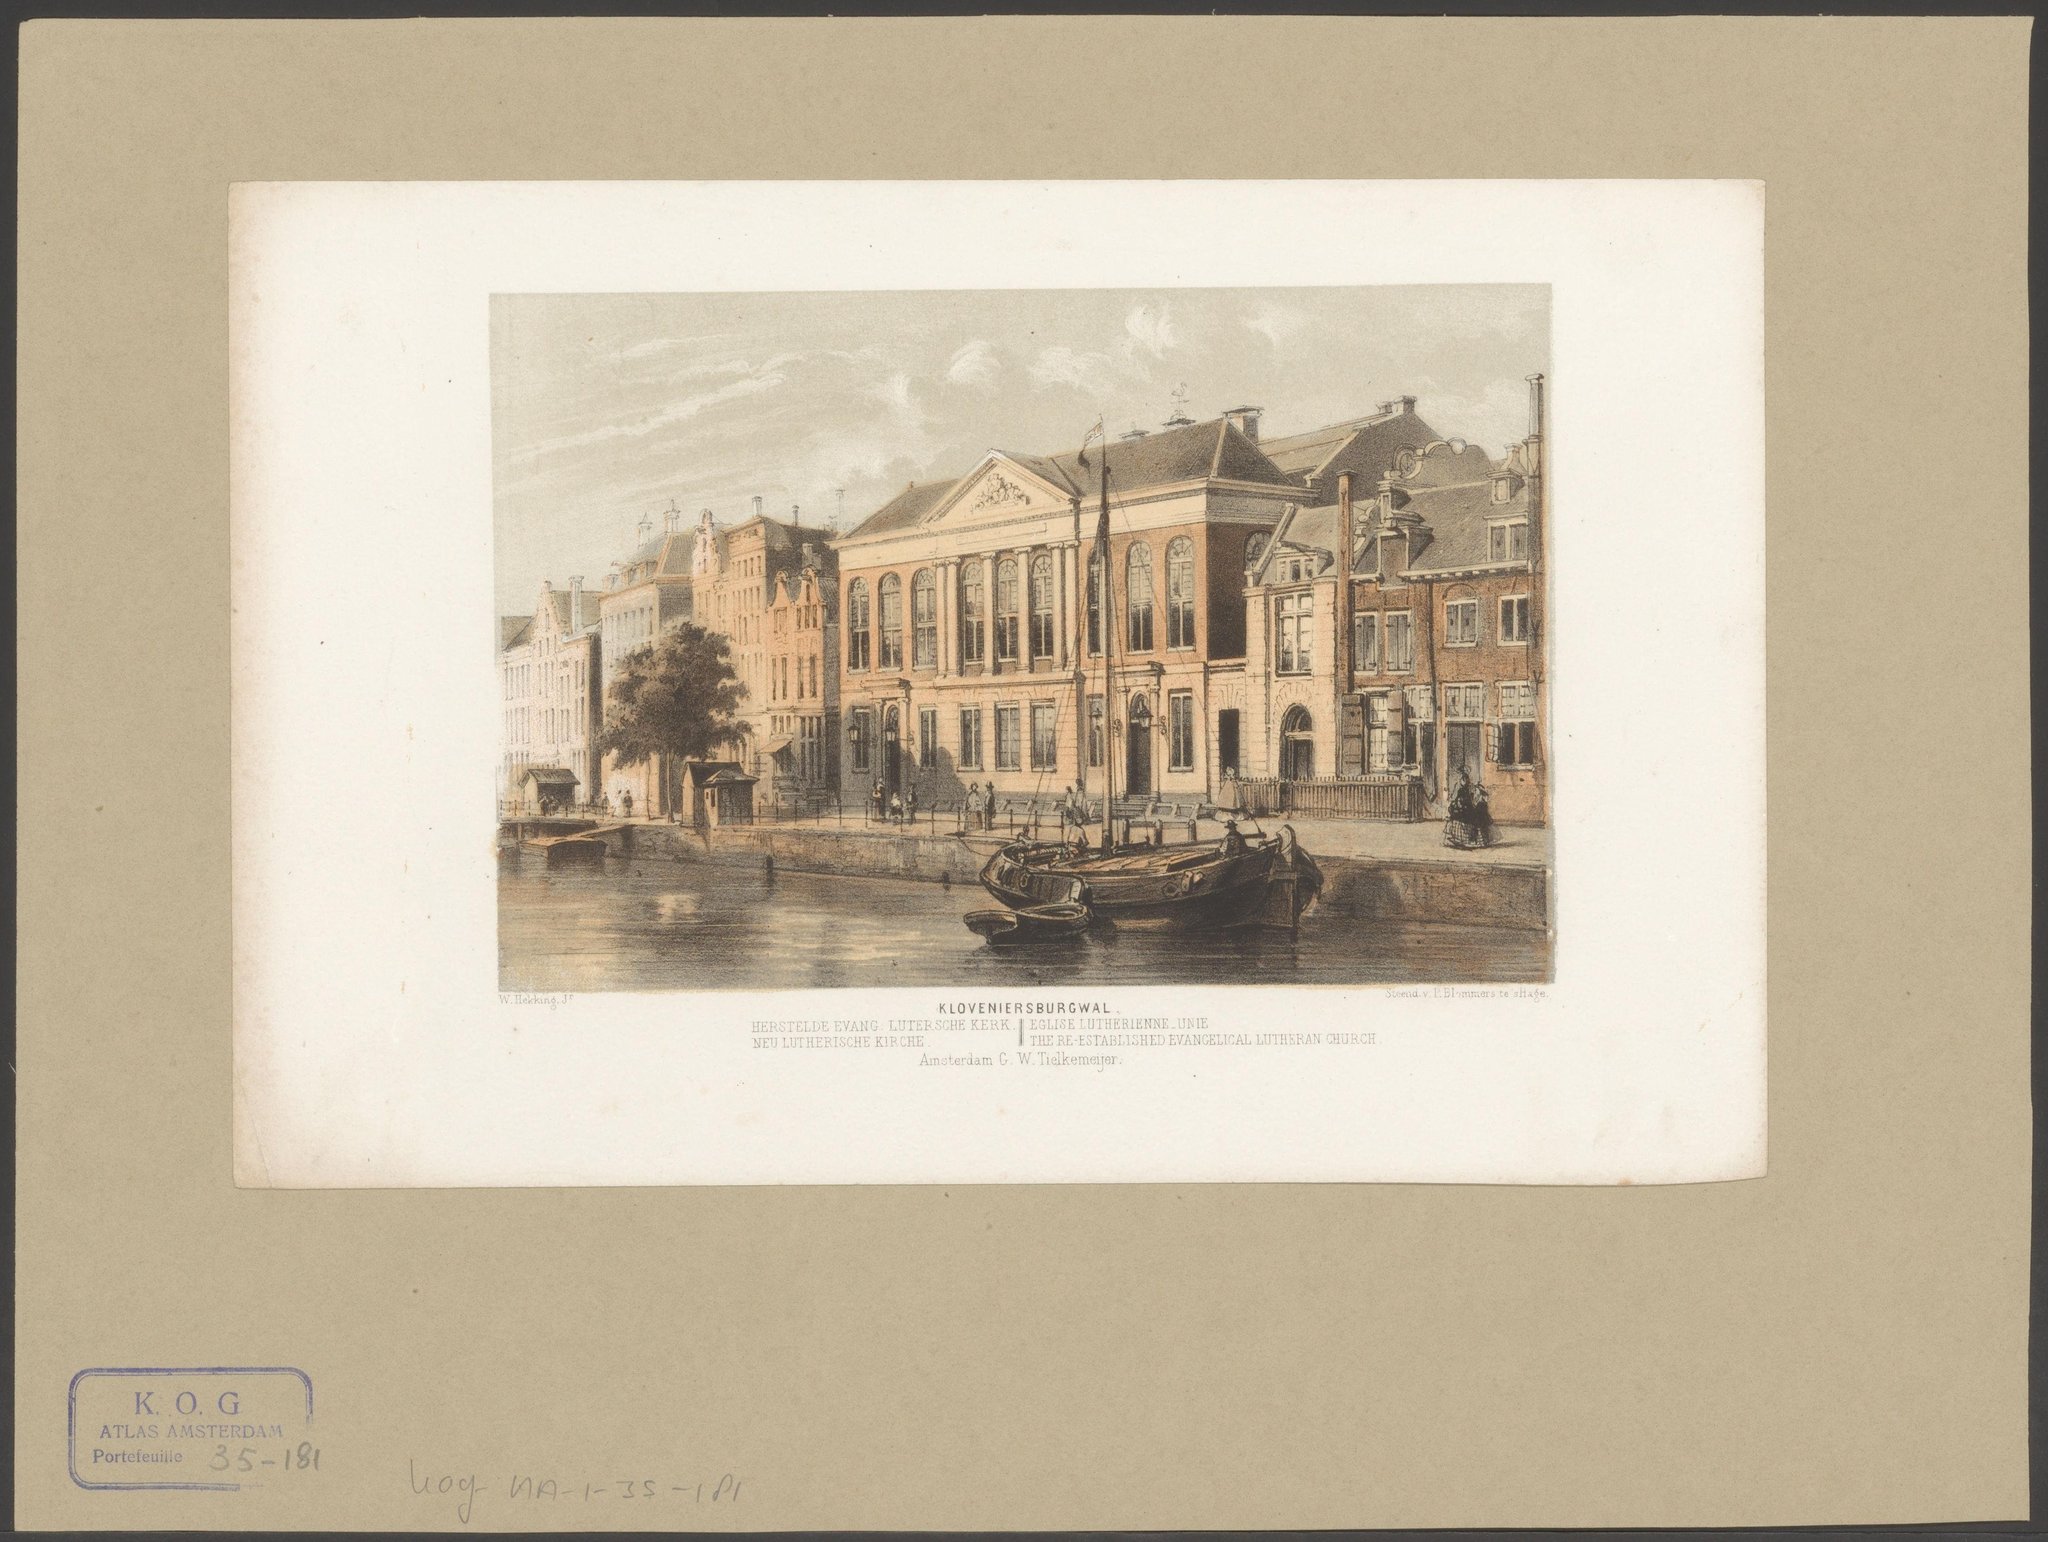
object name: print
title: Kloveniersburgwal / Herstelde Evang. Lutersch Kerk / Neu Lutherische Kirche / Eglise Lutherienne Unie / The Re-Established Evangelical Lutheran Church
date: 1869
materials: paper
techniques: tone lithography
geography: the hague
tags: protestant churches and denominations (lutherans), church (exterior)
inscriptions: collector's mark: Lugt 1641b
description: Prent uit: Witkamp, Pieter Harme. Amsterdam in Schetsen. 2 dln. Amsterdam: George Wilhelm Tielkemeijer, 1869, dl. 2.